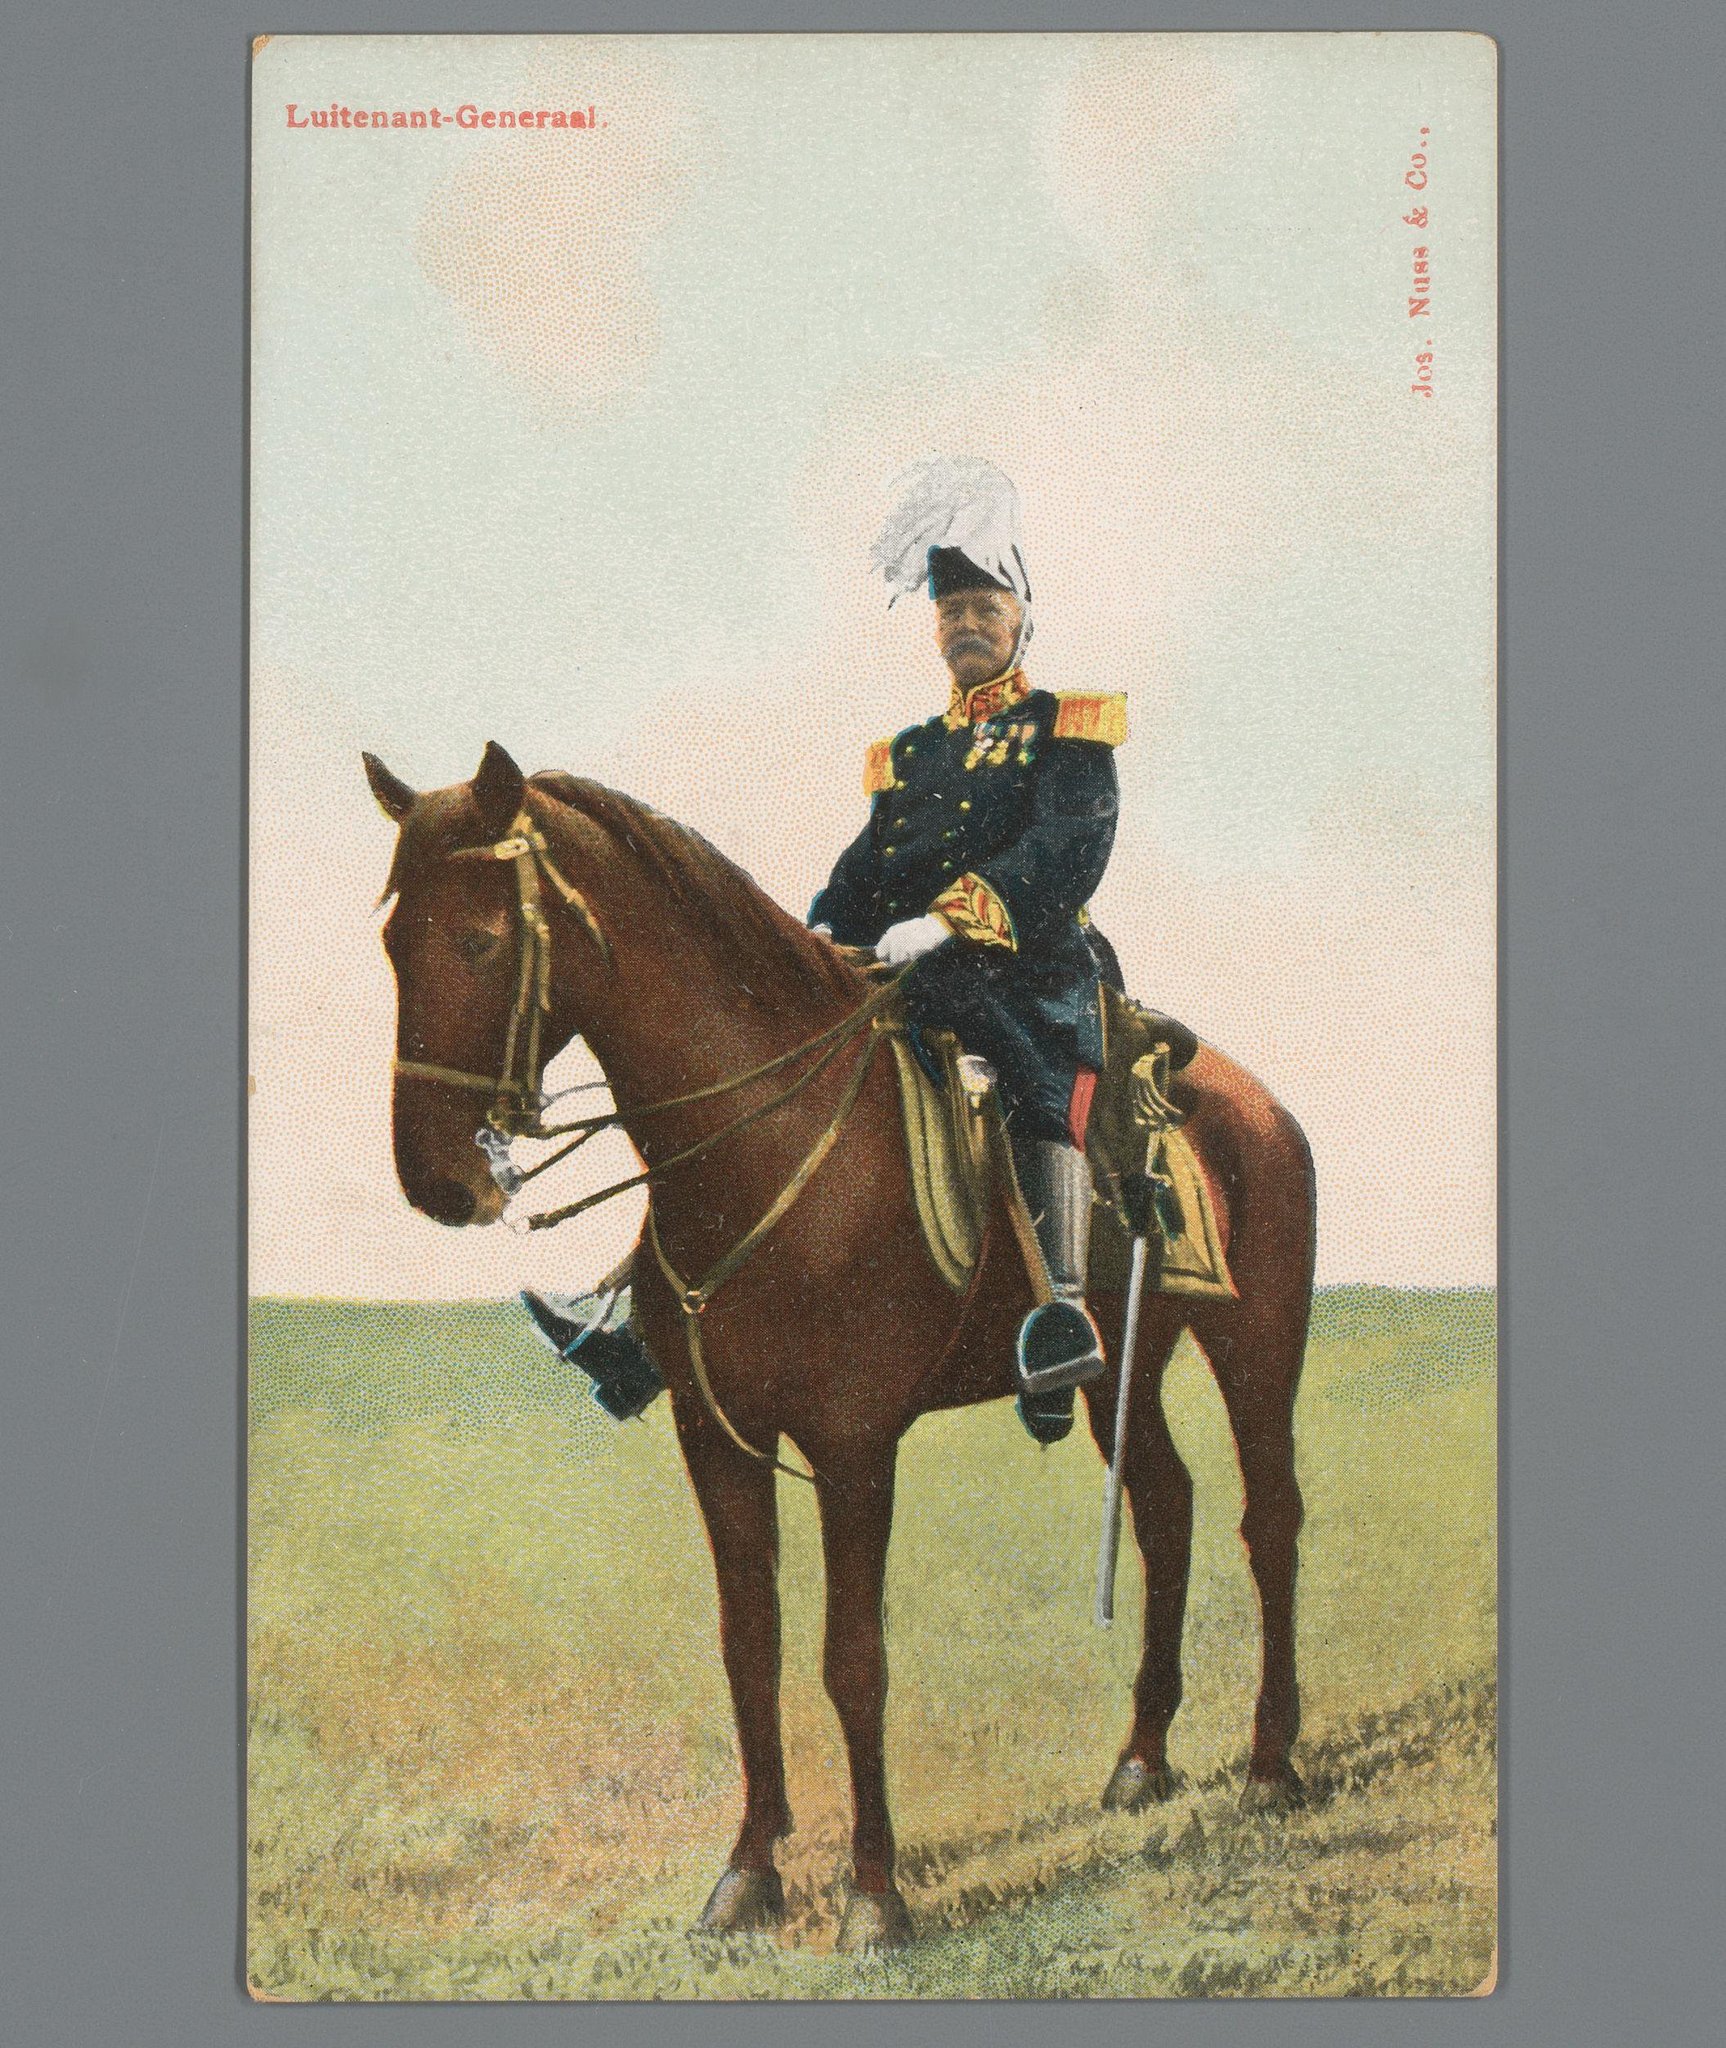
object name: photomechanical print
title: Portret van luitenant-generaal Arthur Kool te paard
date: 1905-1909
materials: paper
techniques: four-color autotype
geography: haarlem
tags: maastricht, commander-in-chief, general, marshal, historical persons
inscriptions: inscription: ‘68, Uniformen’, inscription: ‘BRIEFKAART/ (CARTE POSTALE)/ Algemeene Postvereeniging (Union postale universelle)/ DRUKWERK/ No. 1 AUTEURSRECHT VERZEKERD OVEREENKOMSTIG/ DE WET, 28 JUNI 1881, STAATSBLAD NO 124 .'./ Bij verzending/ als "drukwerk" de/ woorden briefkaart/ carte postale door-/ schrappen en alleen/ naam en datum/ er op schrijven.’